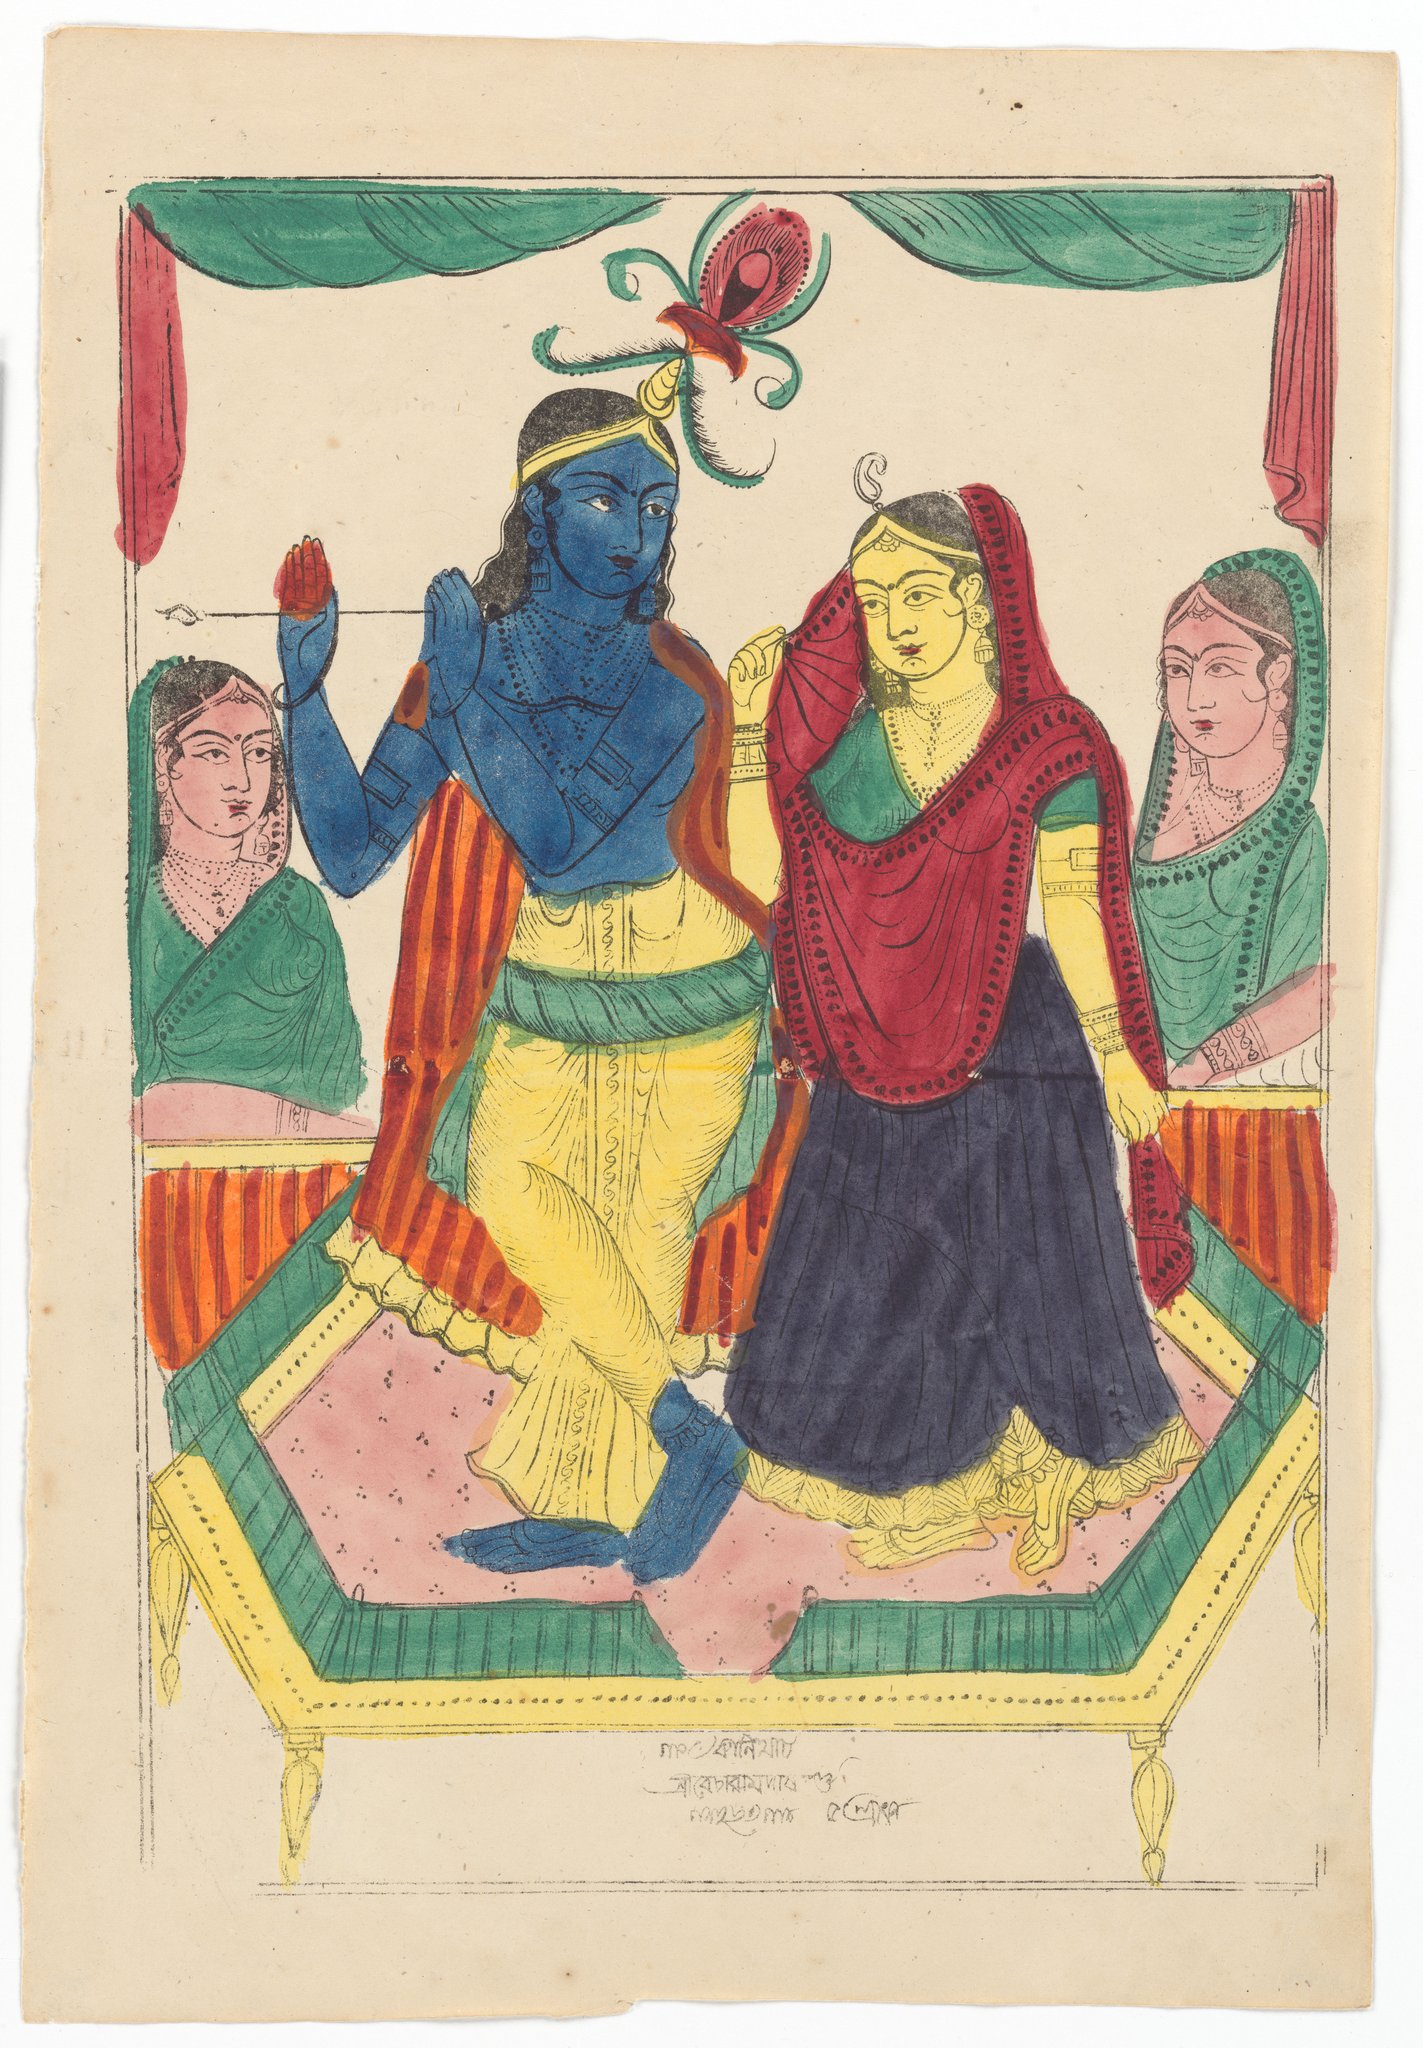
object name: lithograph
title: Krishna and Radha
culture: indian, west bengal, kalighat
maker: becharam das dutta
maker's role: artist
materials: glaze, watercolor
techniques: lithograph, printing